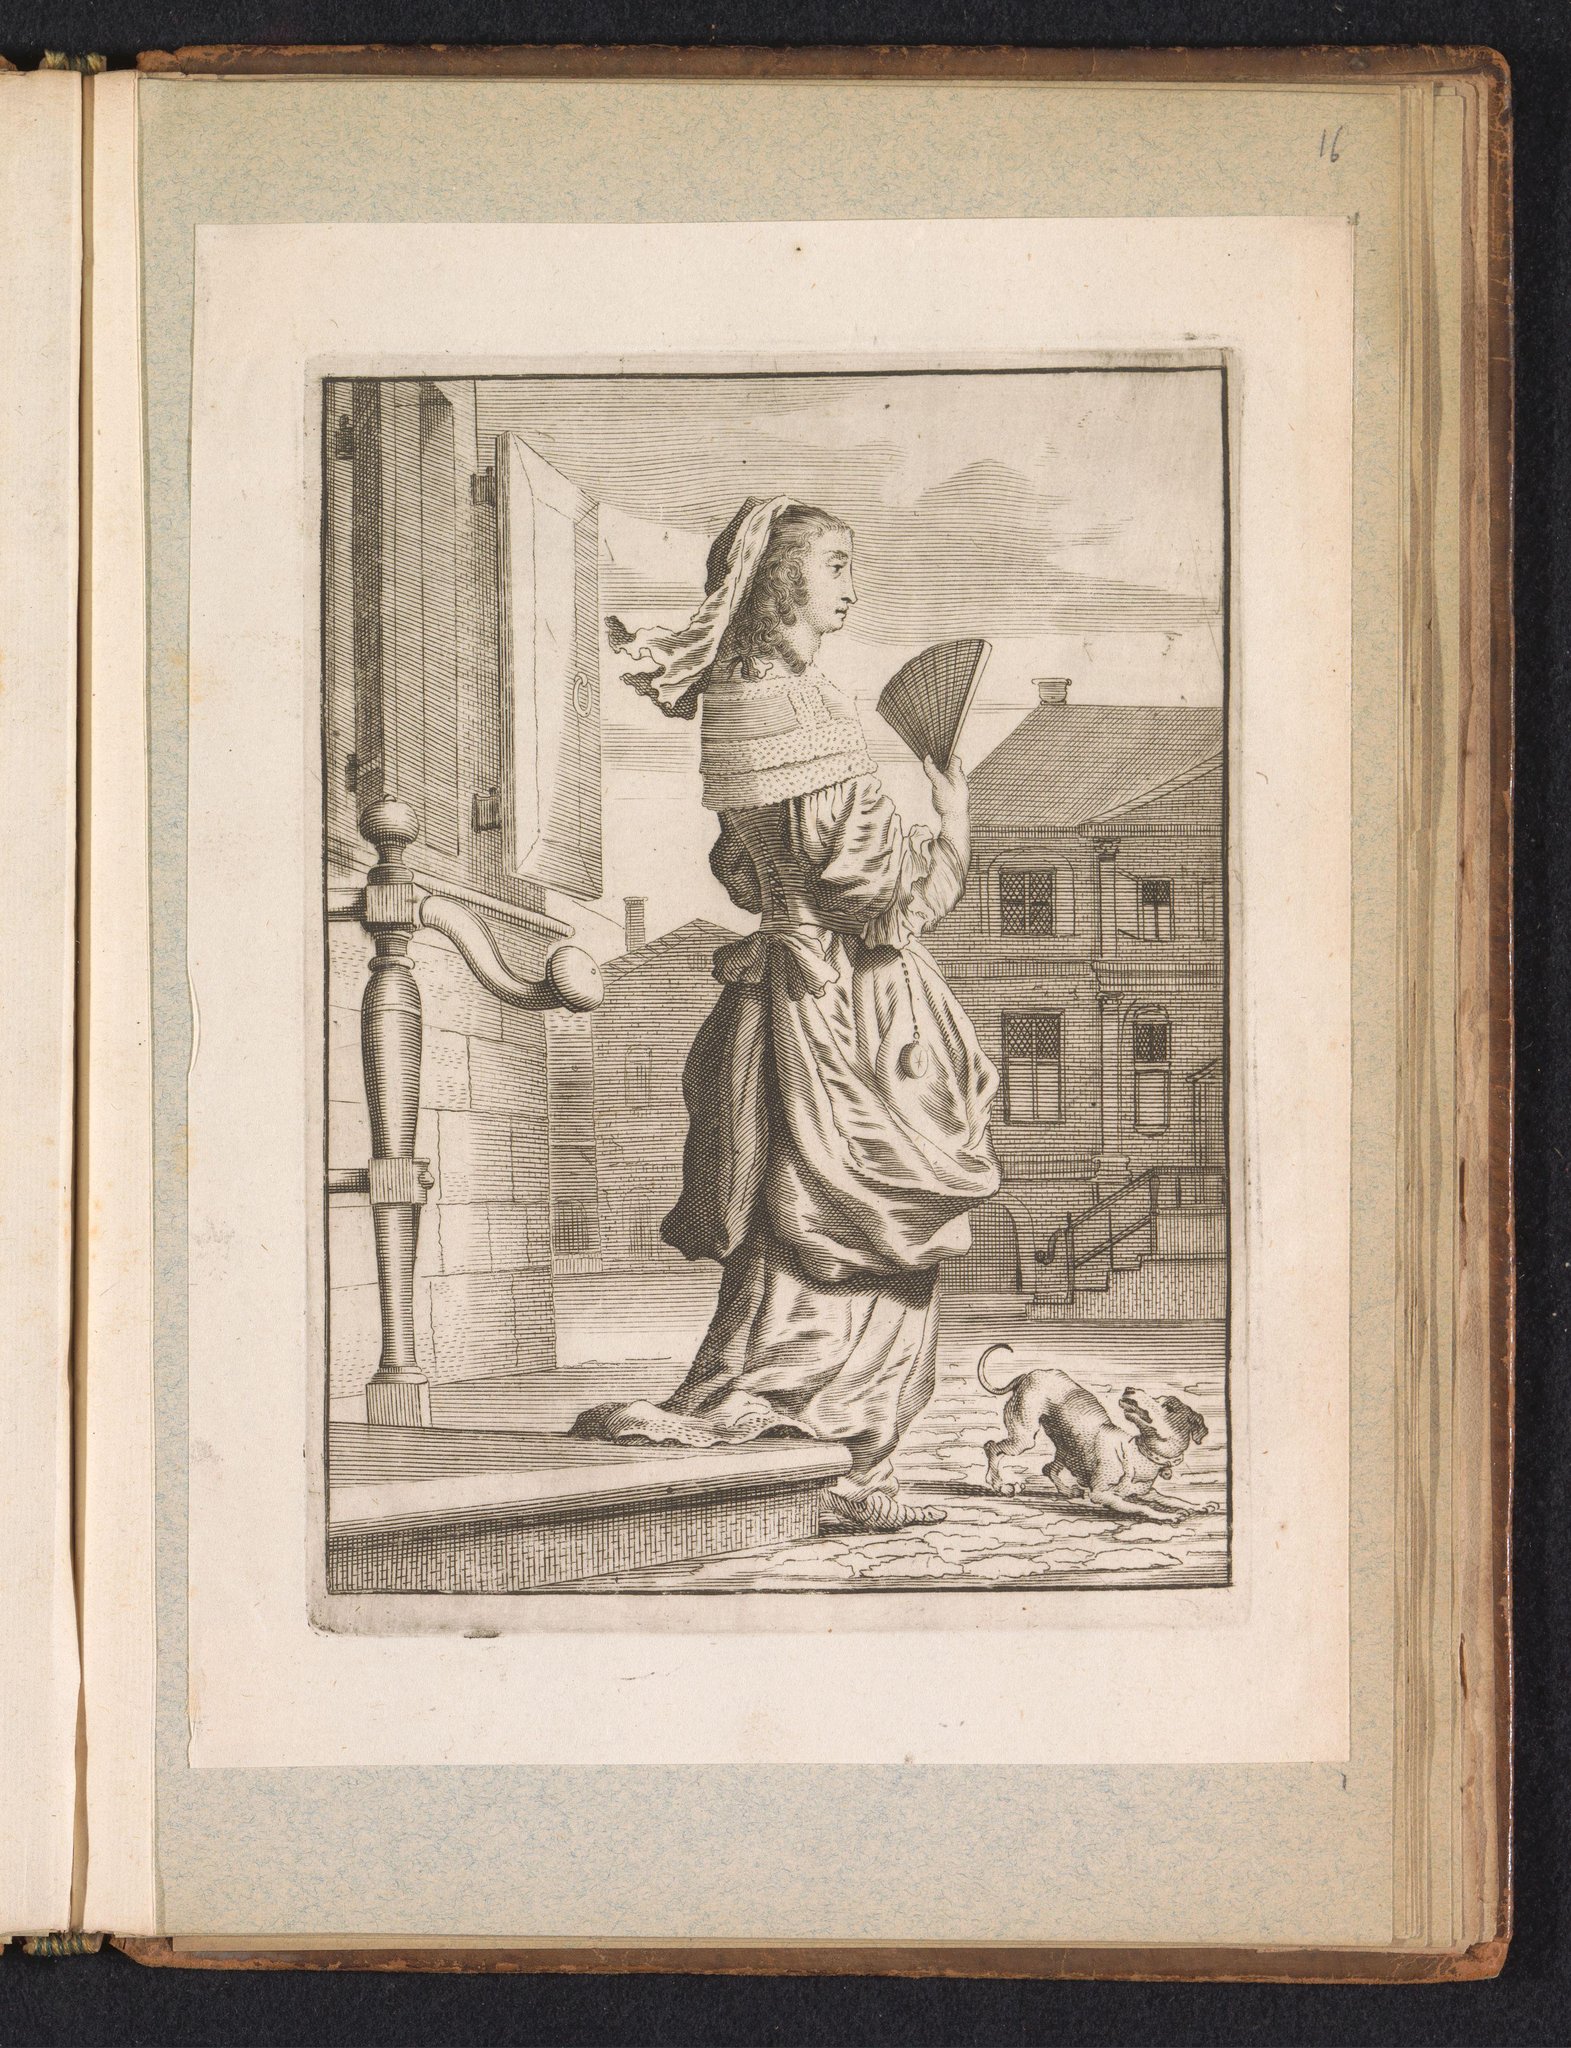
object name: album leaf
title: Dame met waaier, lopend op straat, gekleed volgens de mode omstreeks 1660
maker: jan van troyen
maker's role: print maker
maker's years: 1610-1666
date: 1660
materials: paper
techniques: engraving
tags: neck-gear: collar (+ women's clothes), skirt (+ women's clothes), dress, gown (+ women's clothes), fan (+ women's clothes), sleeves (+ women's clothes), dog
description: Dame, gekleed volgens de mode omstreeks 1660, een huis verlatend. Ze loopt naar rechts, open waaier in de rechterhand. Ze is gekleed in een japon met brede platte kanten kraag. De overrok half opgeschort. Een lint in het haar.